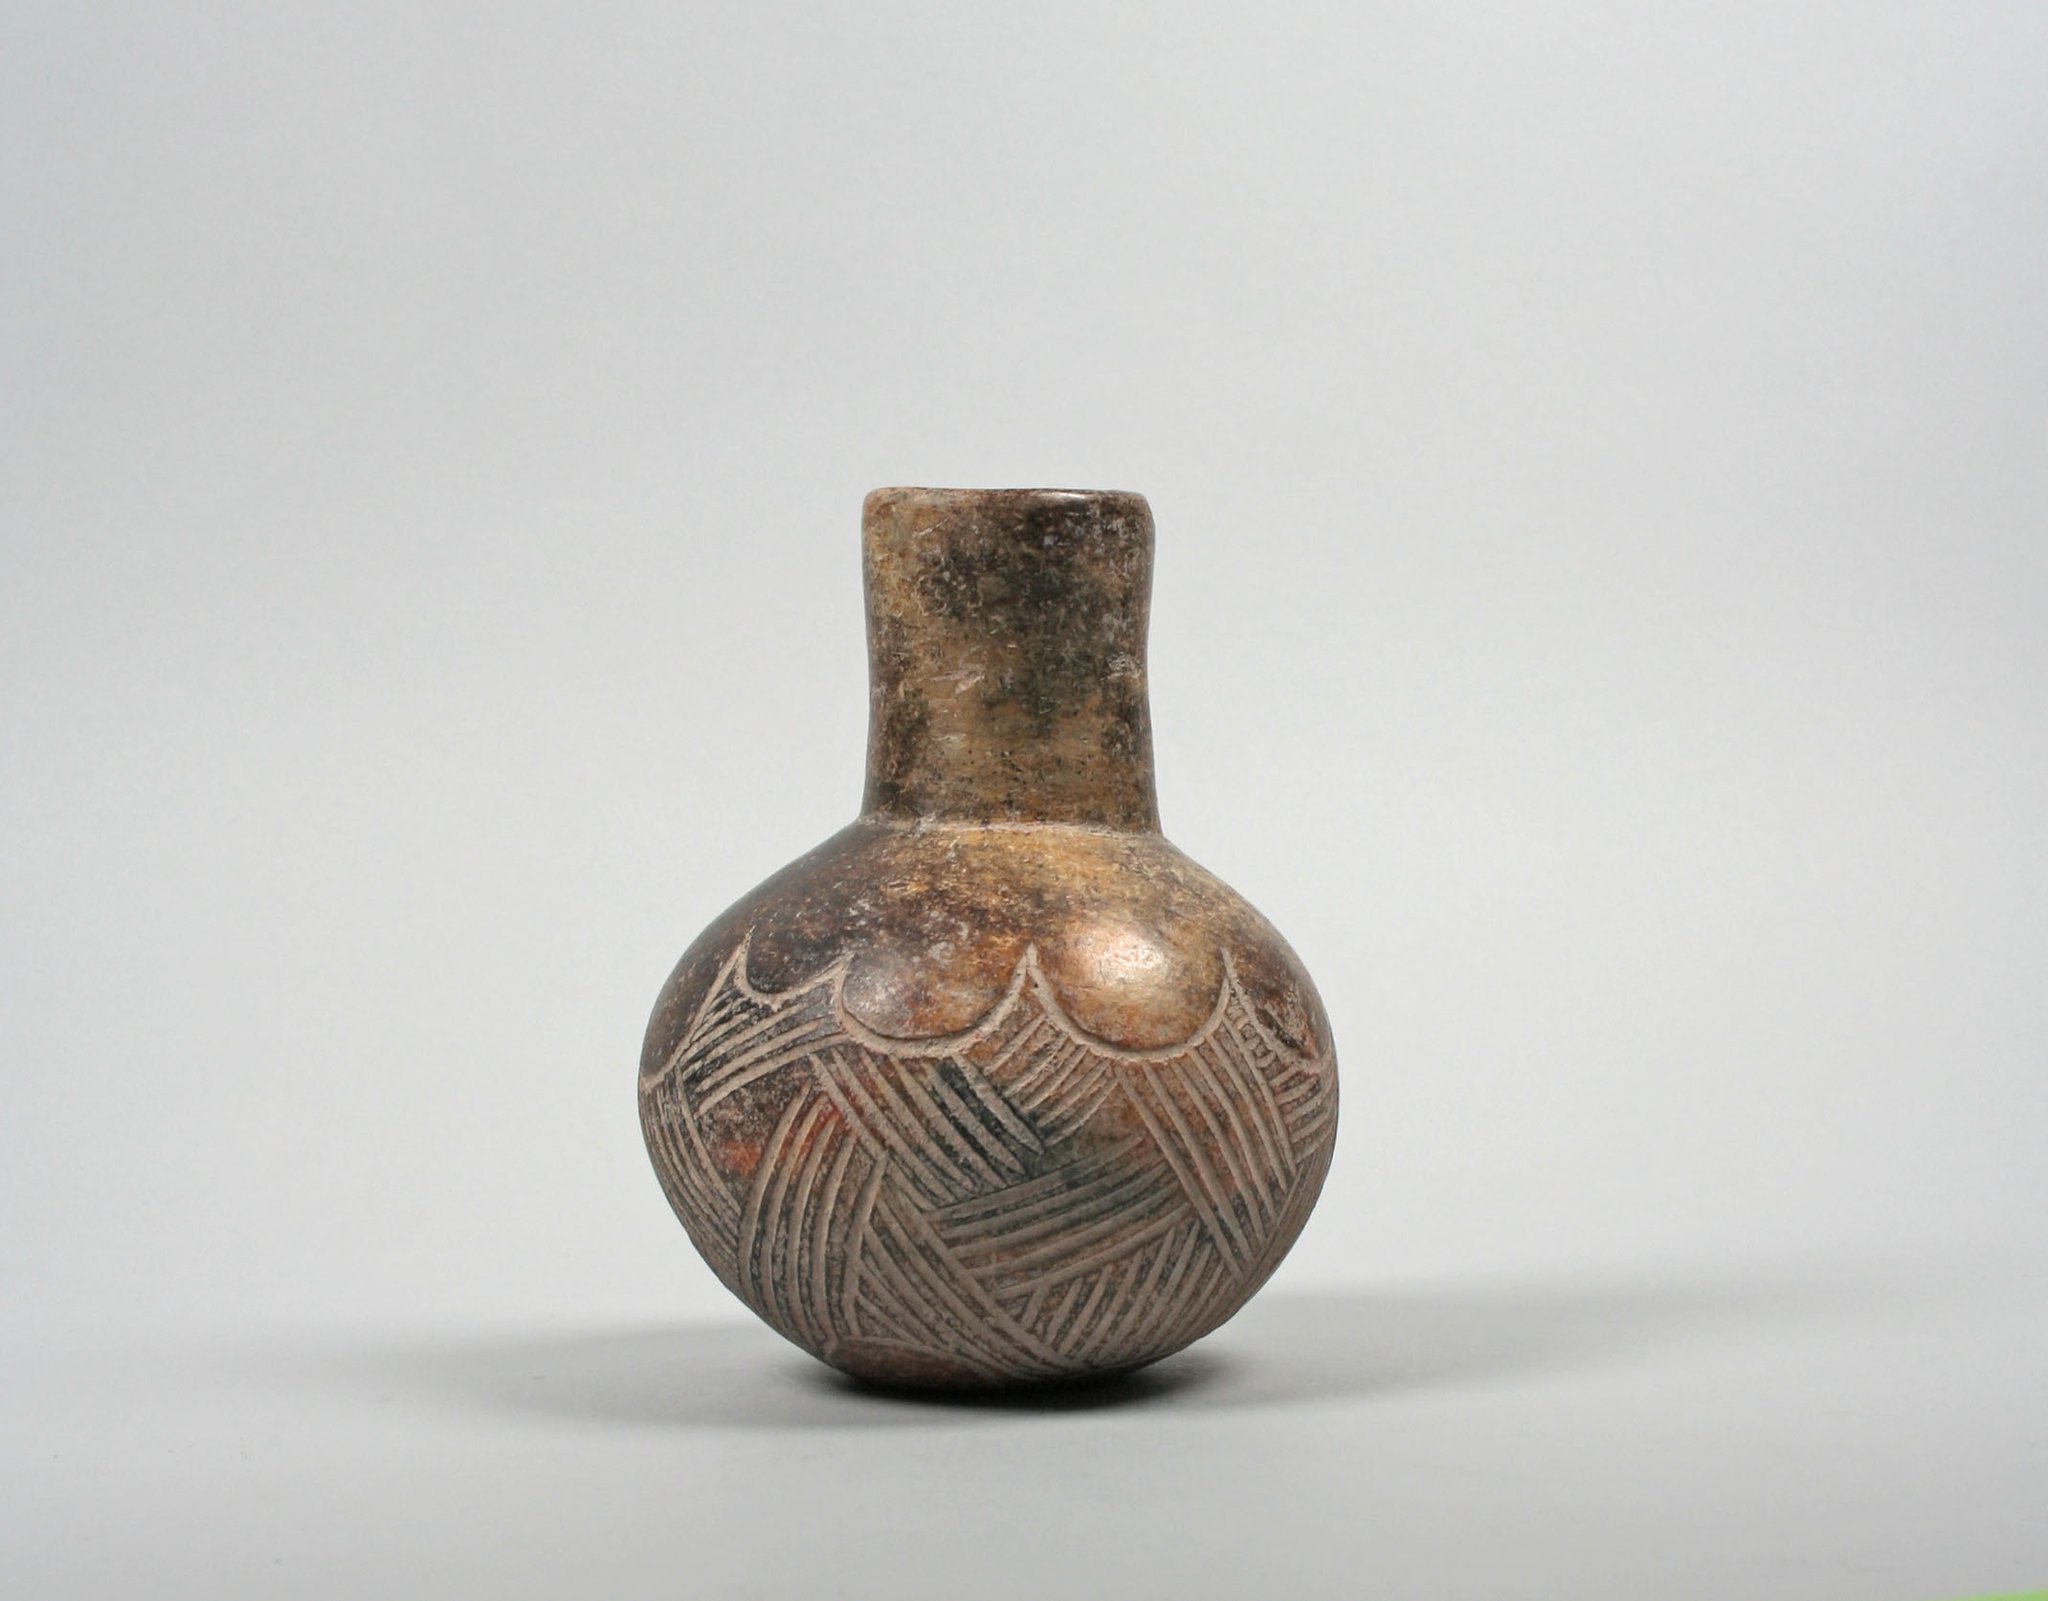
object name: bottle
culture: olmec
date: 1200-801 BCE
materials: ceramic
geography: mexico